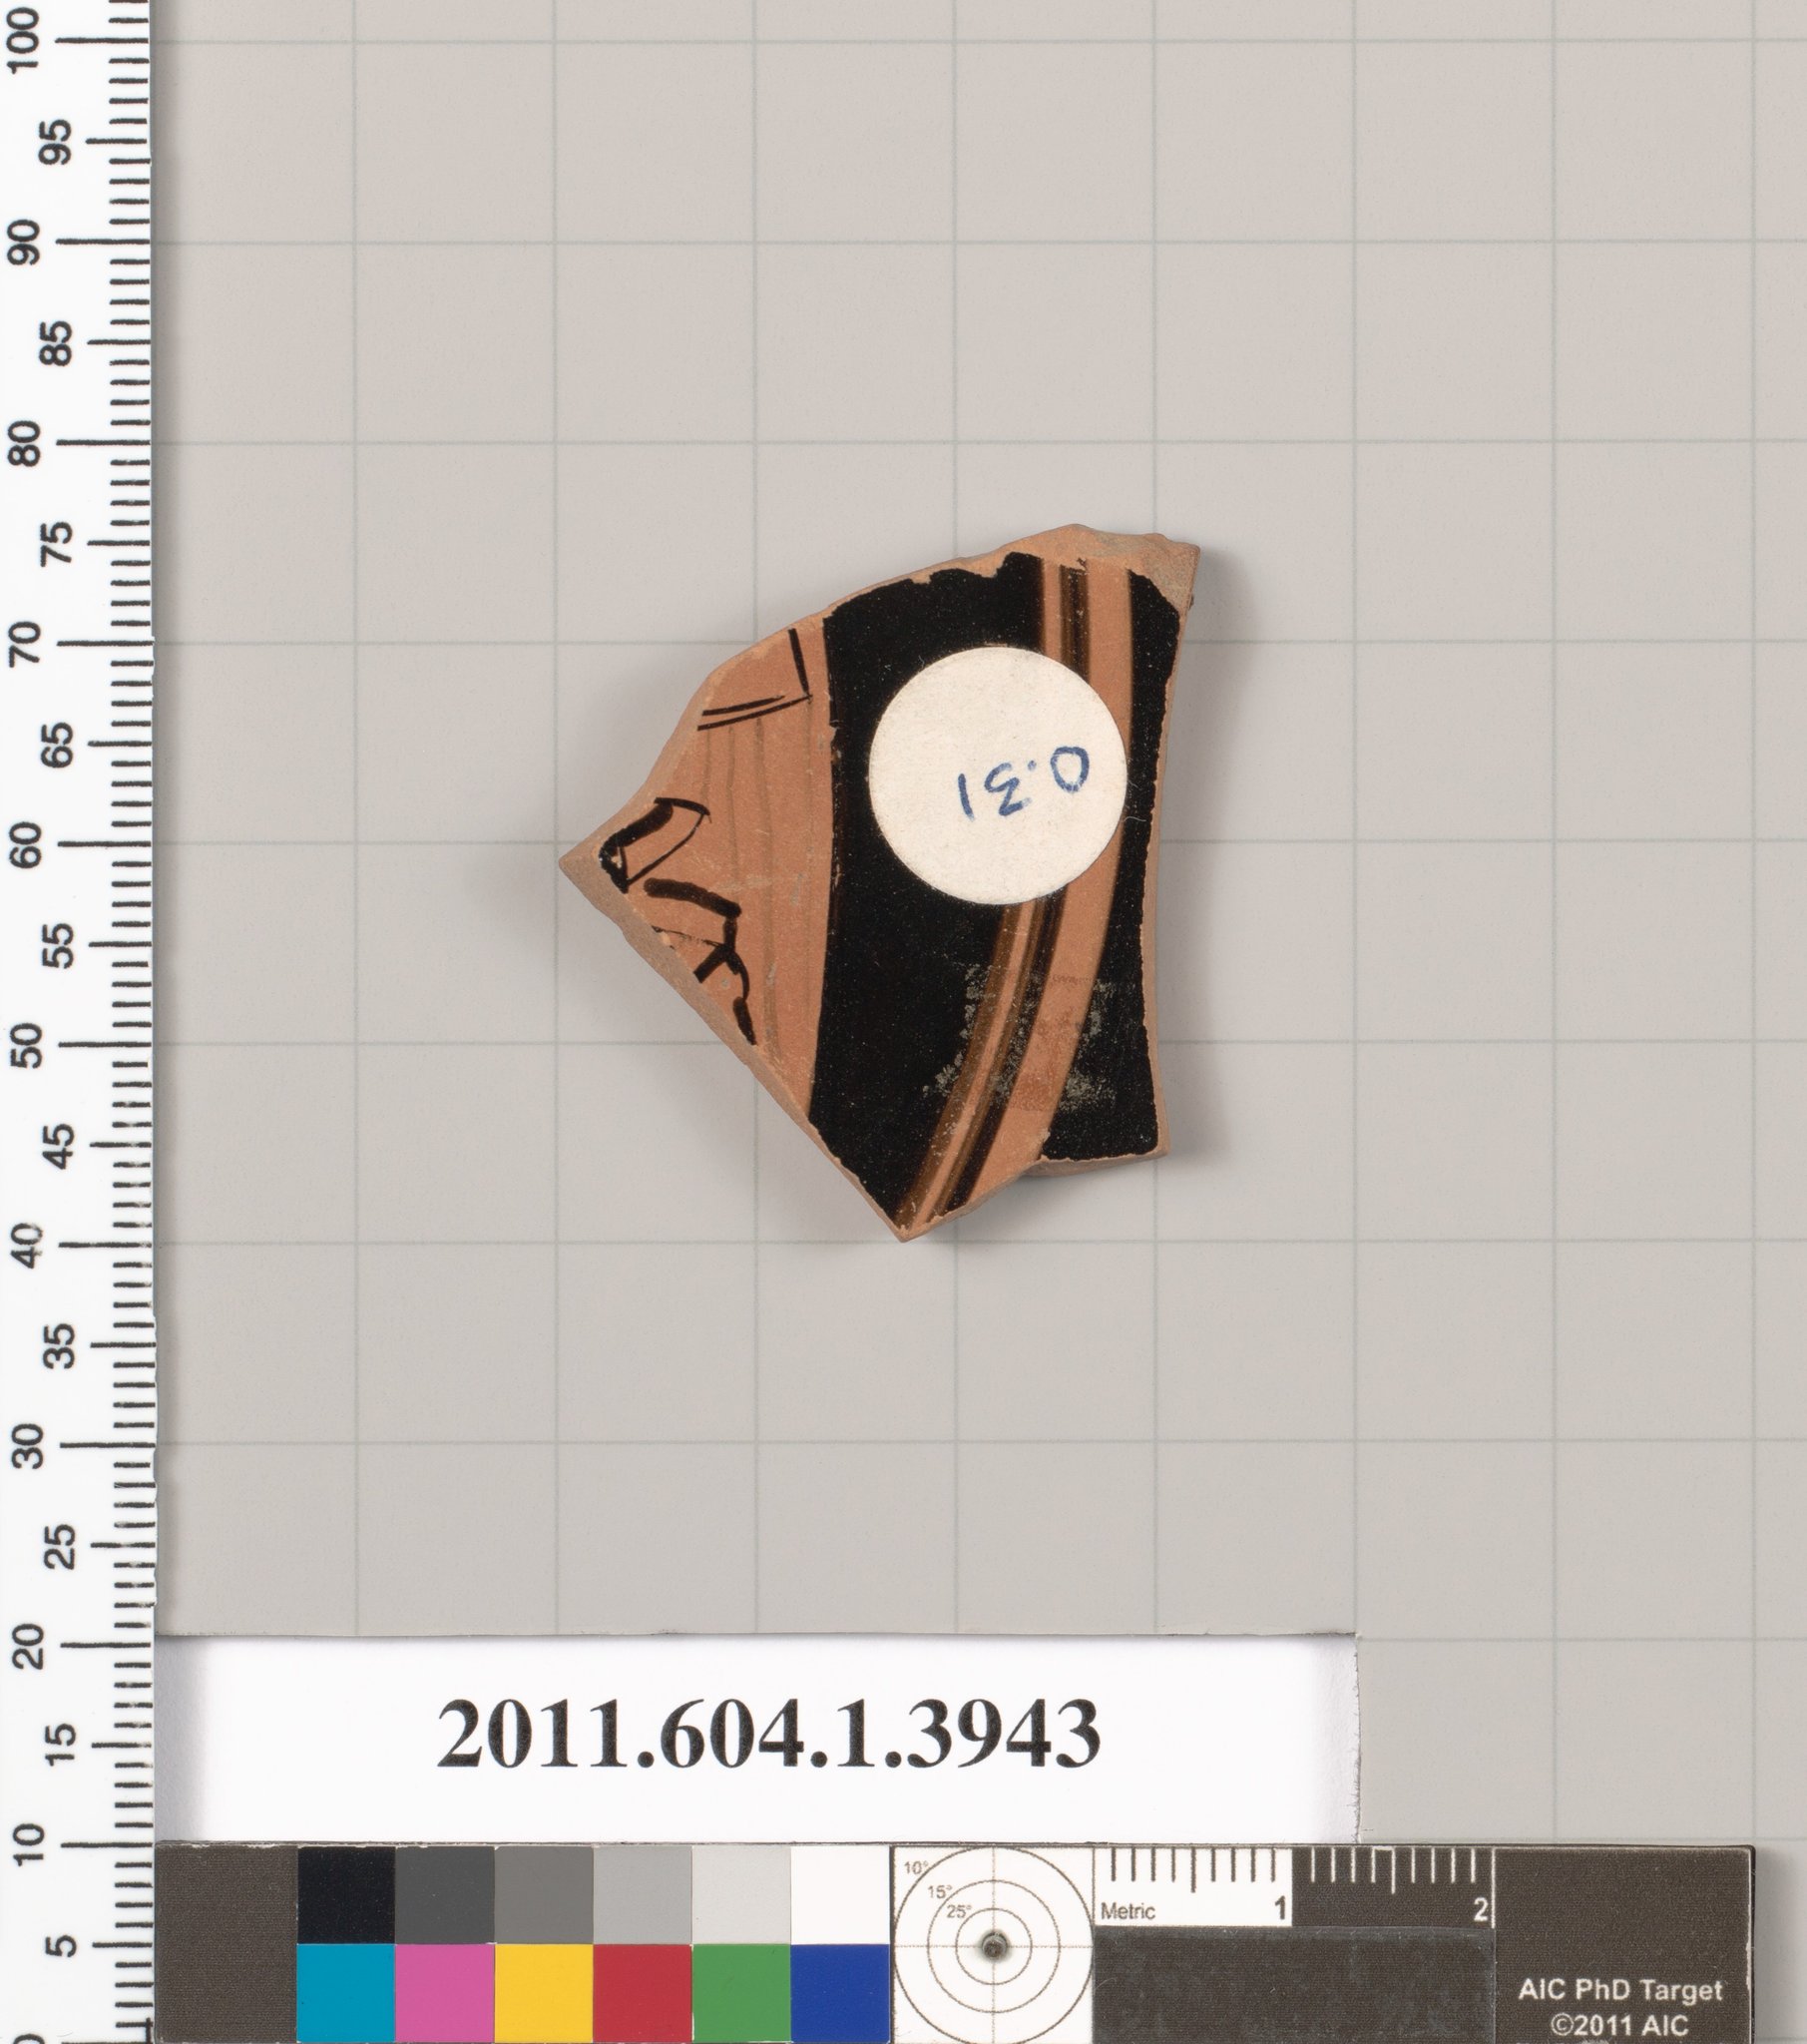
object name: kylix fragment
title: Terracotta fragment of a kylix (drinking cup)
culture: greek, attic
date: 510-480 BCE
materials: terracotta